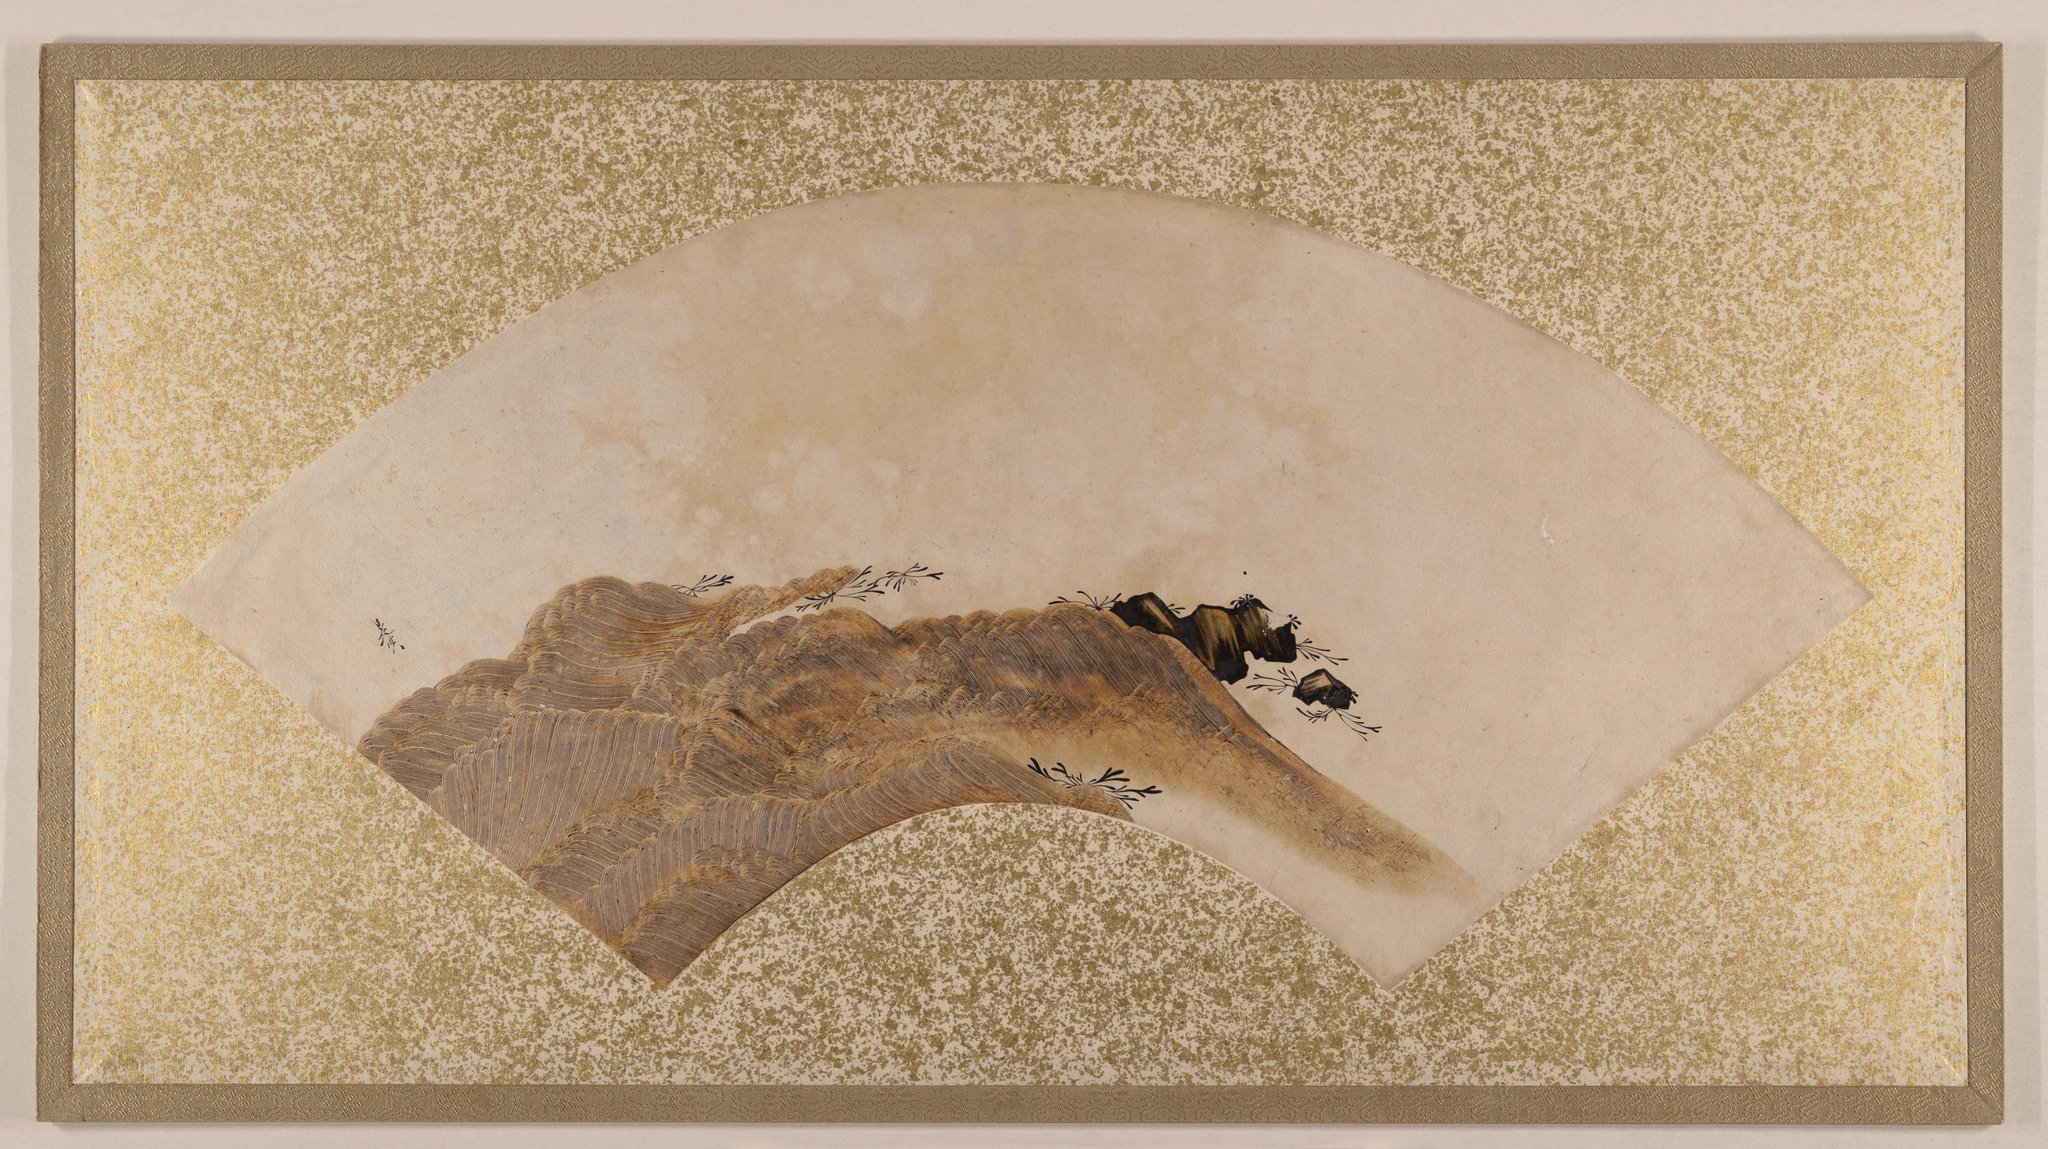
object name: album leaf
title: Waves and Rocks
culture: japanese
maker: shibata zeshin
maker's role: artist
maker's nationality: japanese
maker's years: 1807-1891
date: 1867-1900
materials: paper, paint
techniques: painting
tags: landscapes,waves